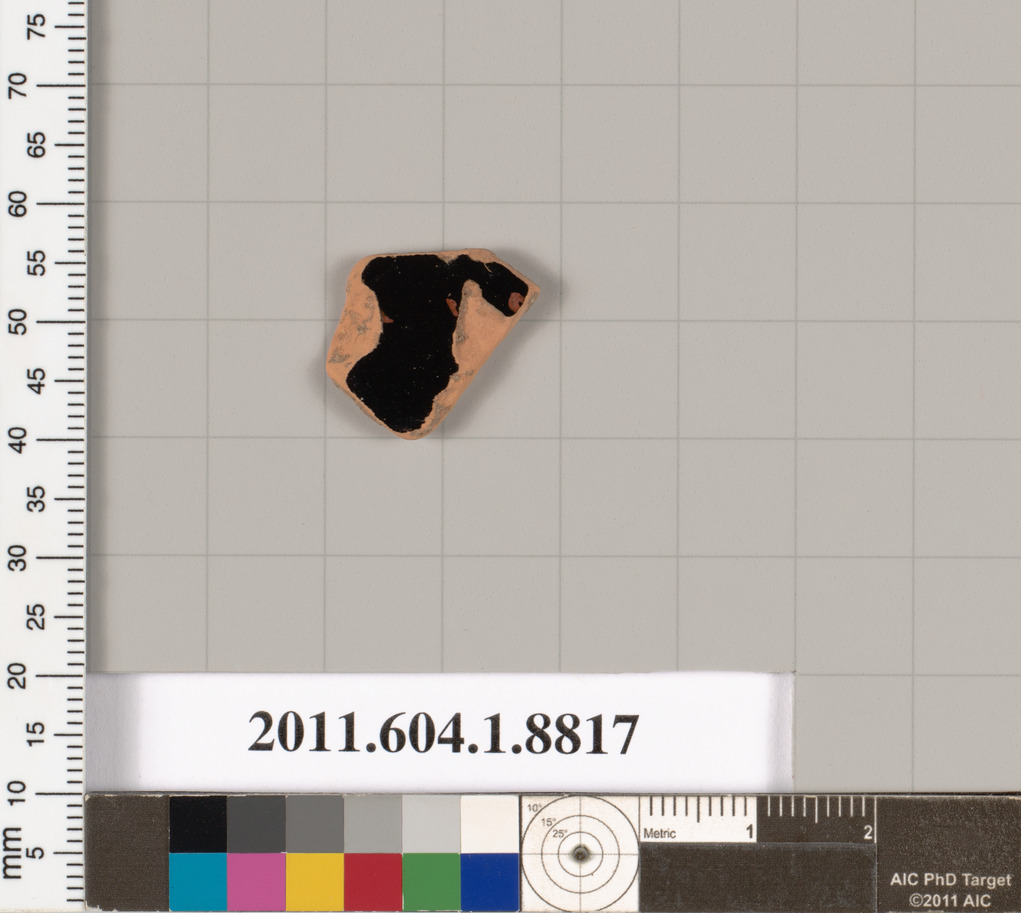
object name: kylix fragment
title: Terracotta fragment of a kylix (cup)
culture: greek, attic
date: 490-470 BCE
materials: terracotta